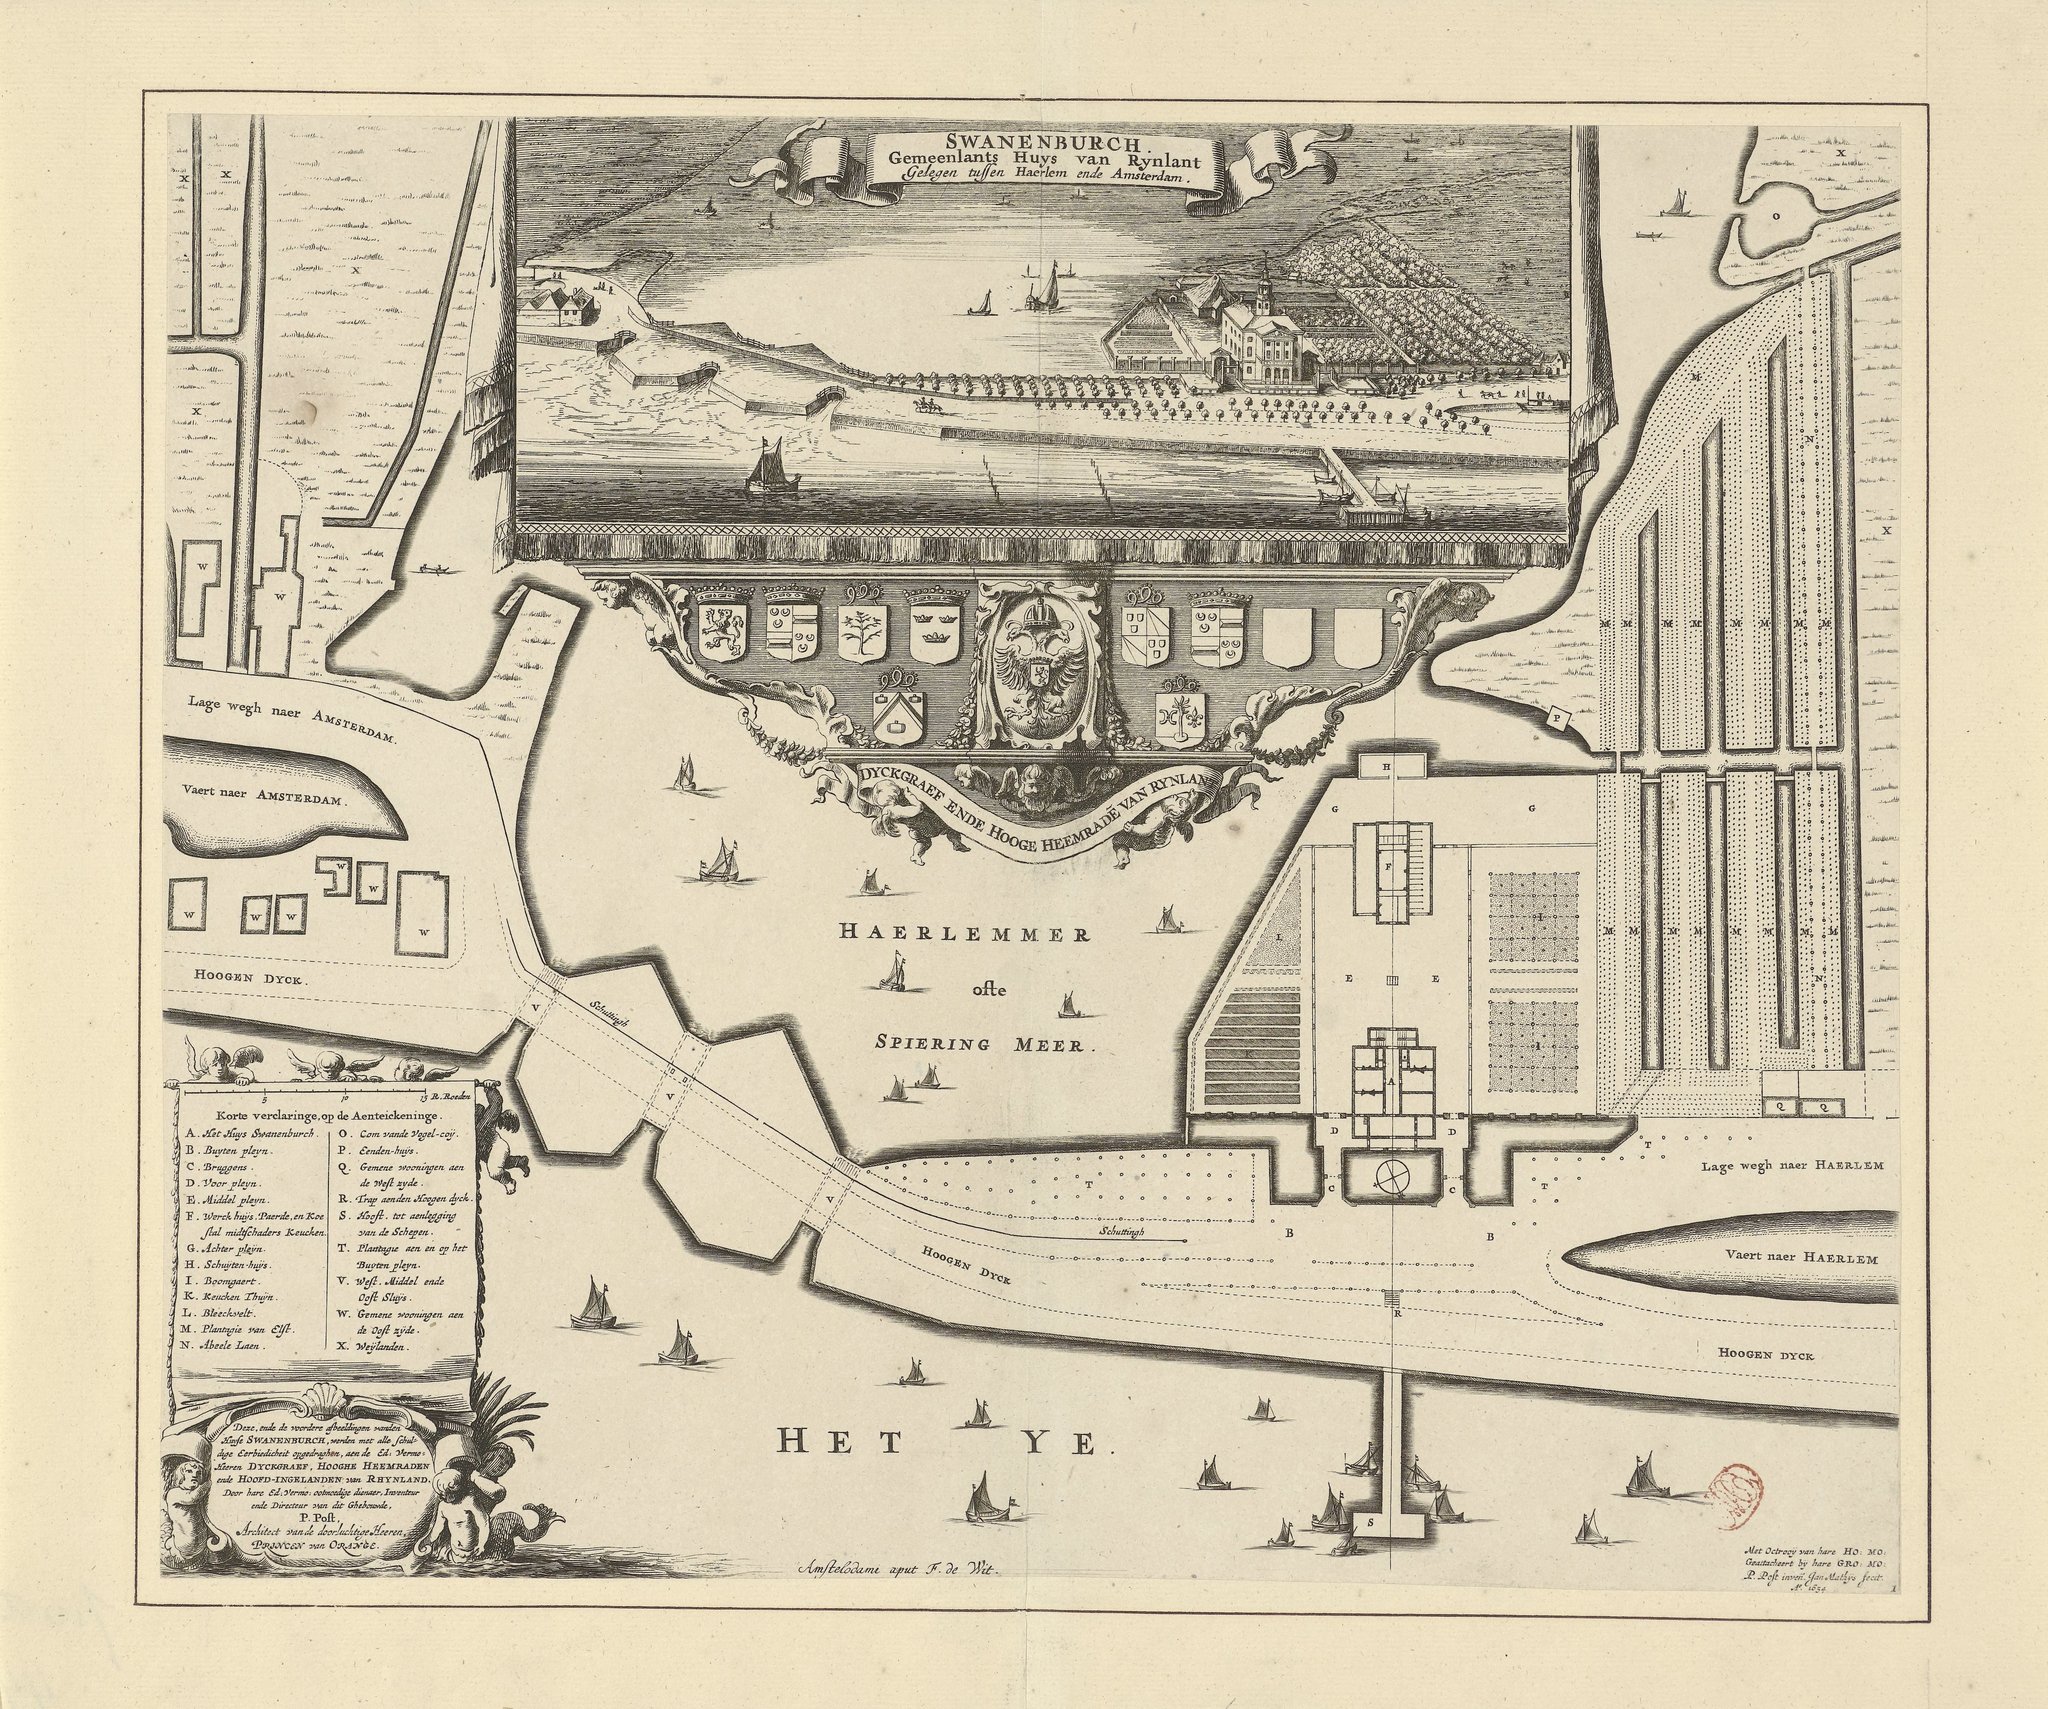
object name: titelprent, frontispice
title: Swanenburg, gemeenlandshuis van Rijnland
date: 1654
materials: paper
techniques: engraving, etching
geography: amsterdam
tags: bird's eye view ~ architectural design or model, plan ~ architecture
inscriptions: collector's mark: Lugt 2228, collector's mark: Lugt 195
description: Swanenburg, het gemeenlandshuis van het hoogheemraadschap van Rijnland, gelegen naast de sluizen van Halfweg, tussen Amsterdam en Haarlem. Boven in het midden een gezicht op Swanenburg in vogelvluchtperspectief, met daaronder de wapenschilden van de dijkgraaf en hoogheemraden van Rijnland. Onder de plattegrond van het huis en de omgeving met boven de sluizen de Haarlemmermeer en onder het IJ. Linksonder de legenda A-X en een schaalstok: 15 R. roeden. Rechtsonder genummerd: 1.